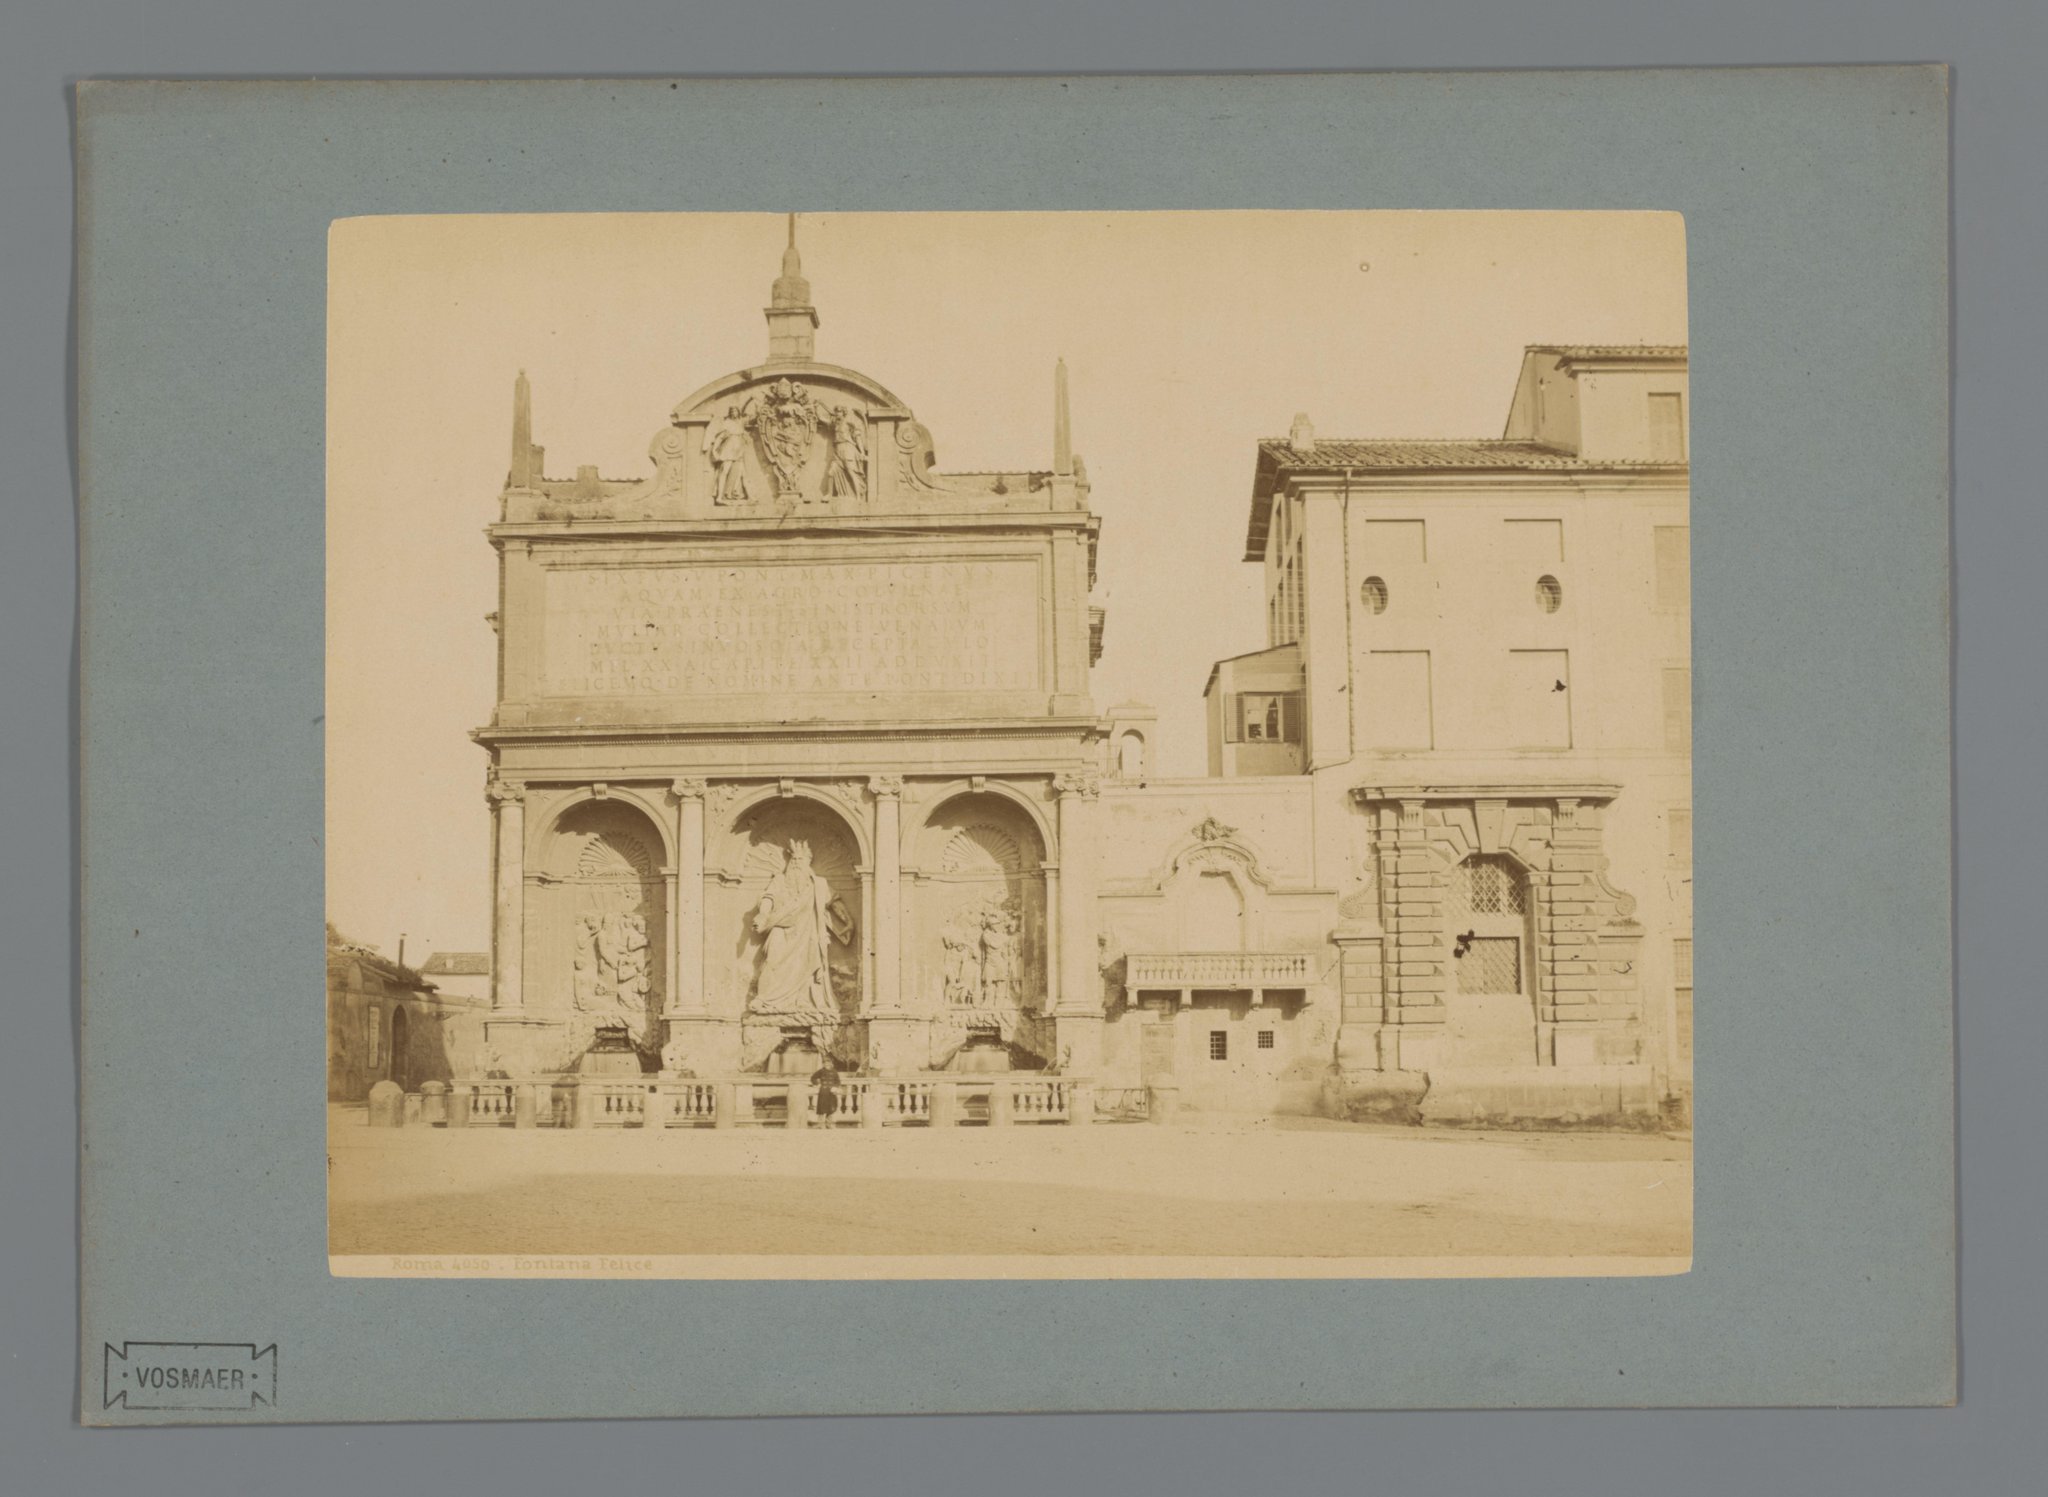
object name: photograph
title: Fontana Felice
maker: Anonymous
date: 1851-1890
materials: cardboard, paper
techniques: albumen print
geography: rome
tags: square, place, circus, etc., ornamental fountain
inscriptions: collector's mark: ‘VOSMAER’, number: ‘4050’